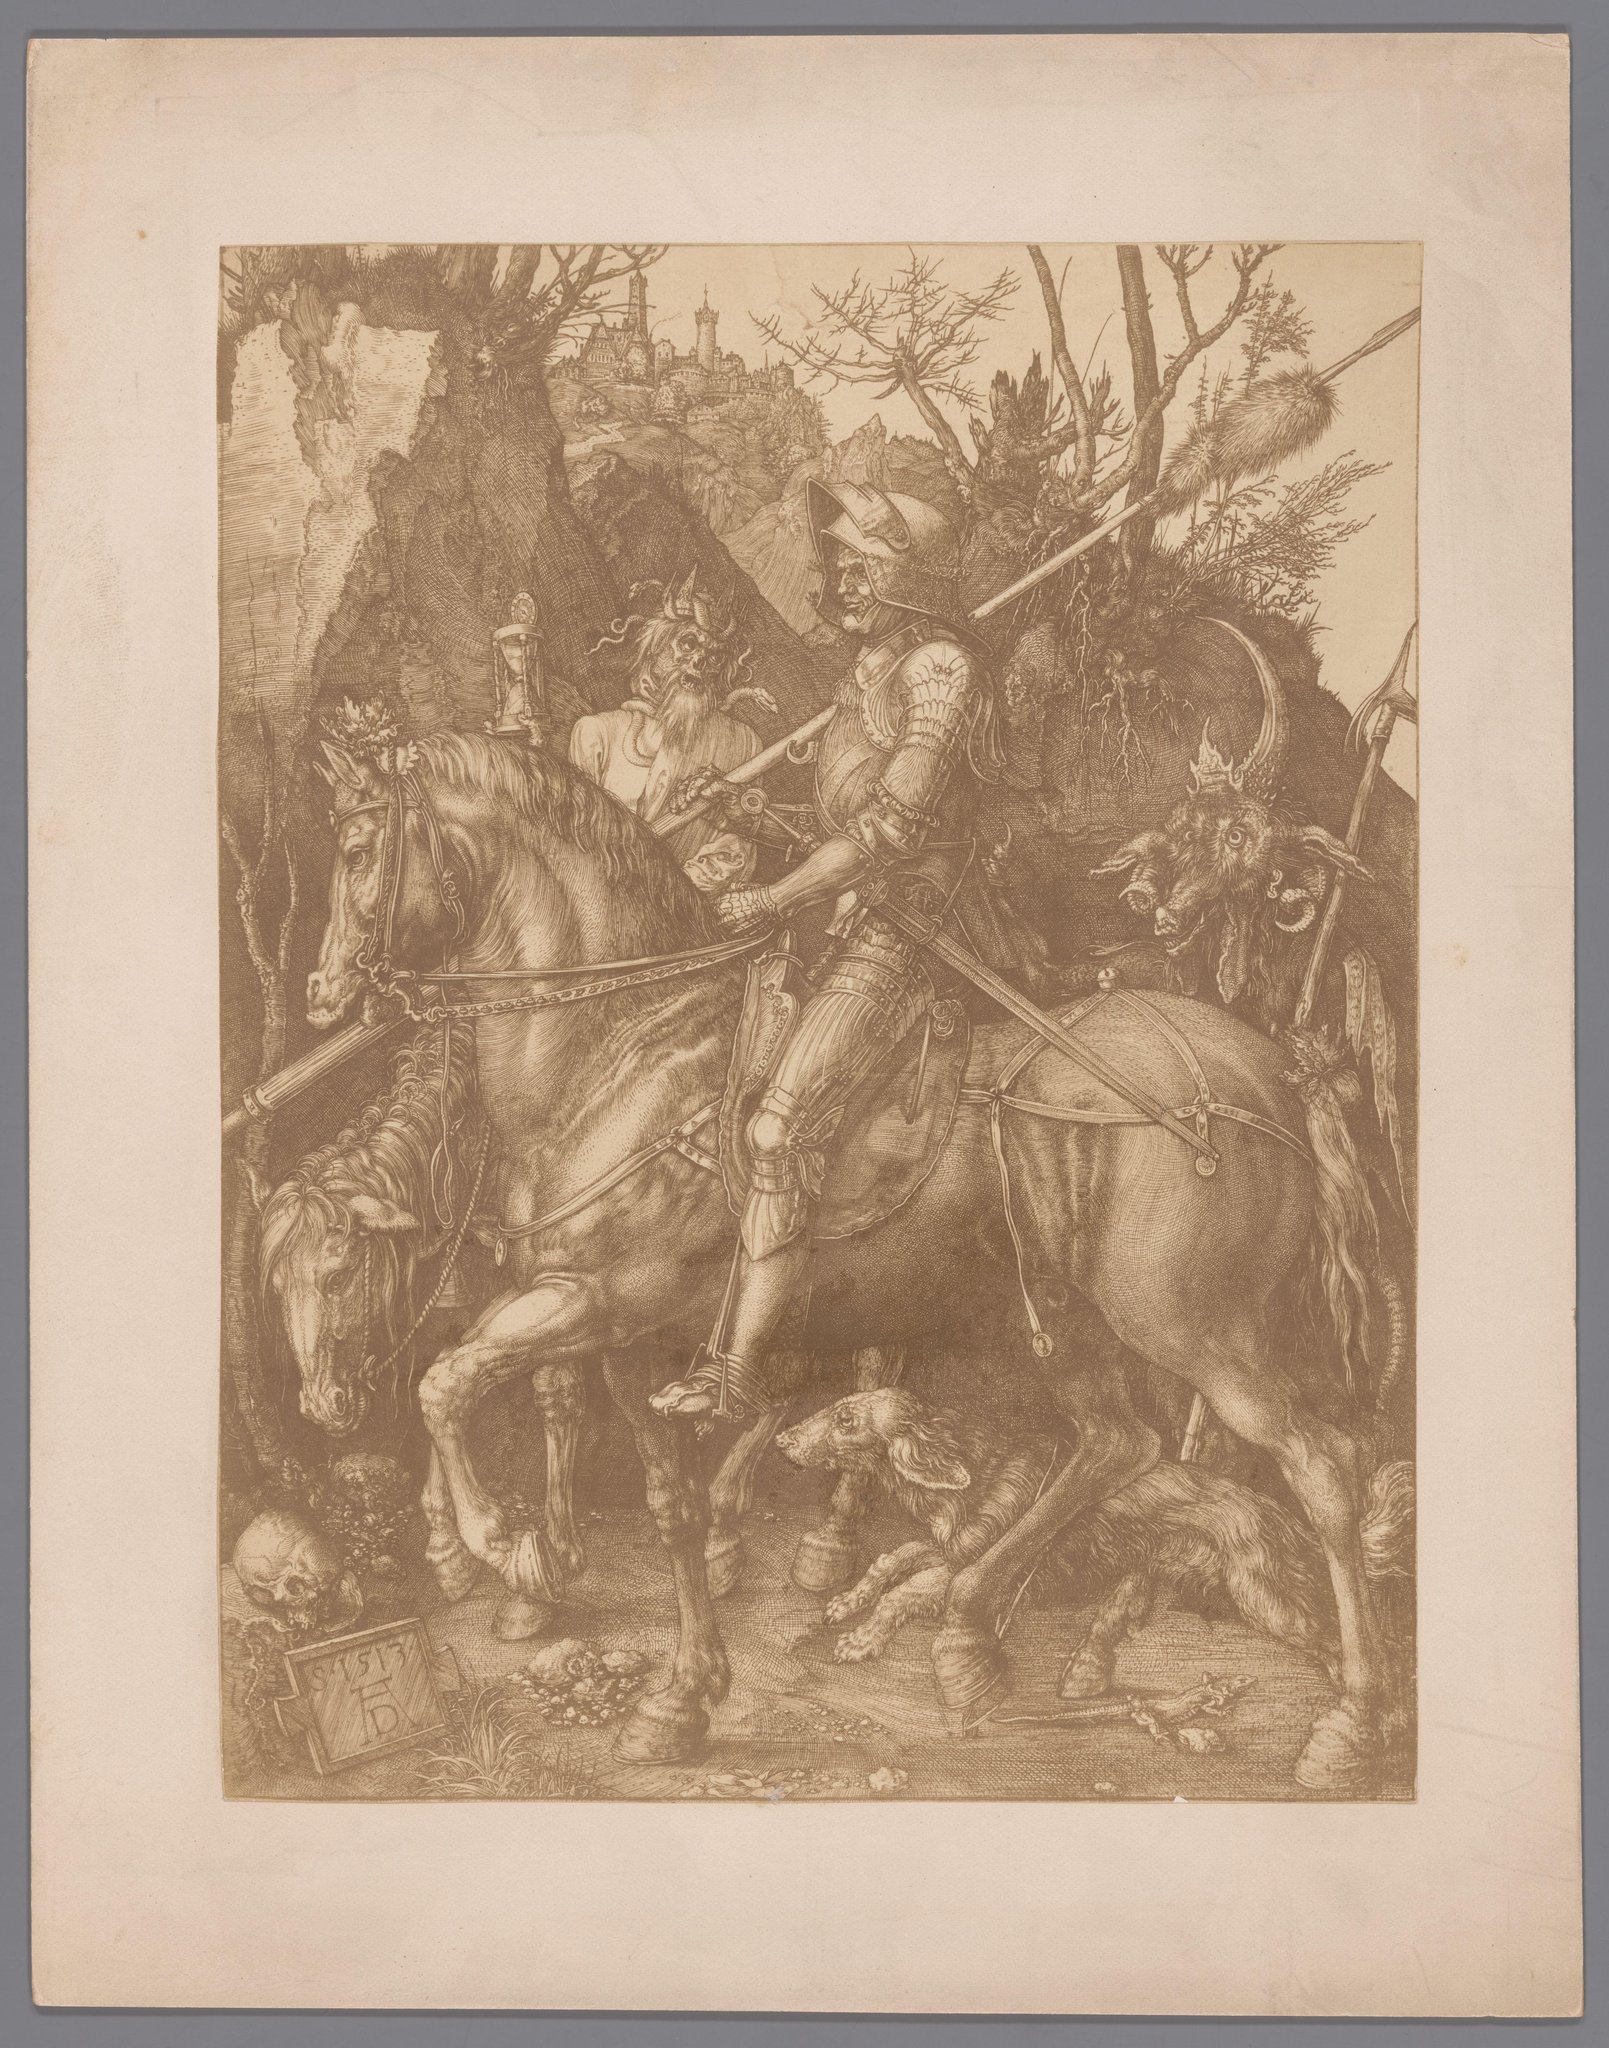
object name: photograph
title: Fotoreproductie van de gravure Ridder, Dood en Duivel door Albrecht Dürer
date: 1910-1940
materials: cardboard, paper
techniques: gelatin silver print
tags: devils in the form of (fabulous) animals, print, e.g.: engraving, etching, lithograph, death as skeleton, knight